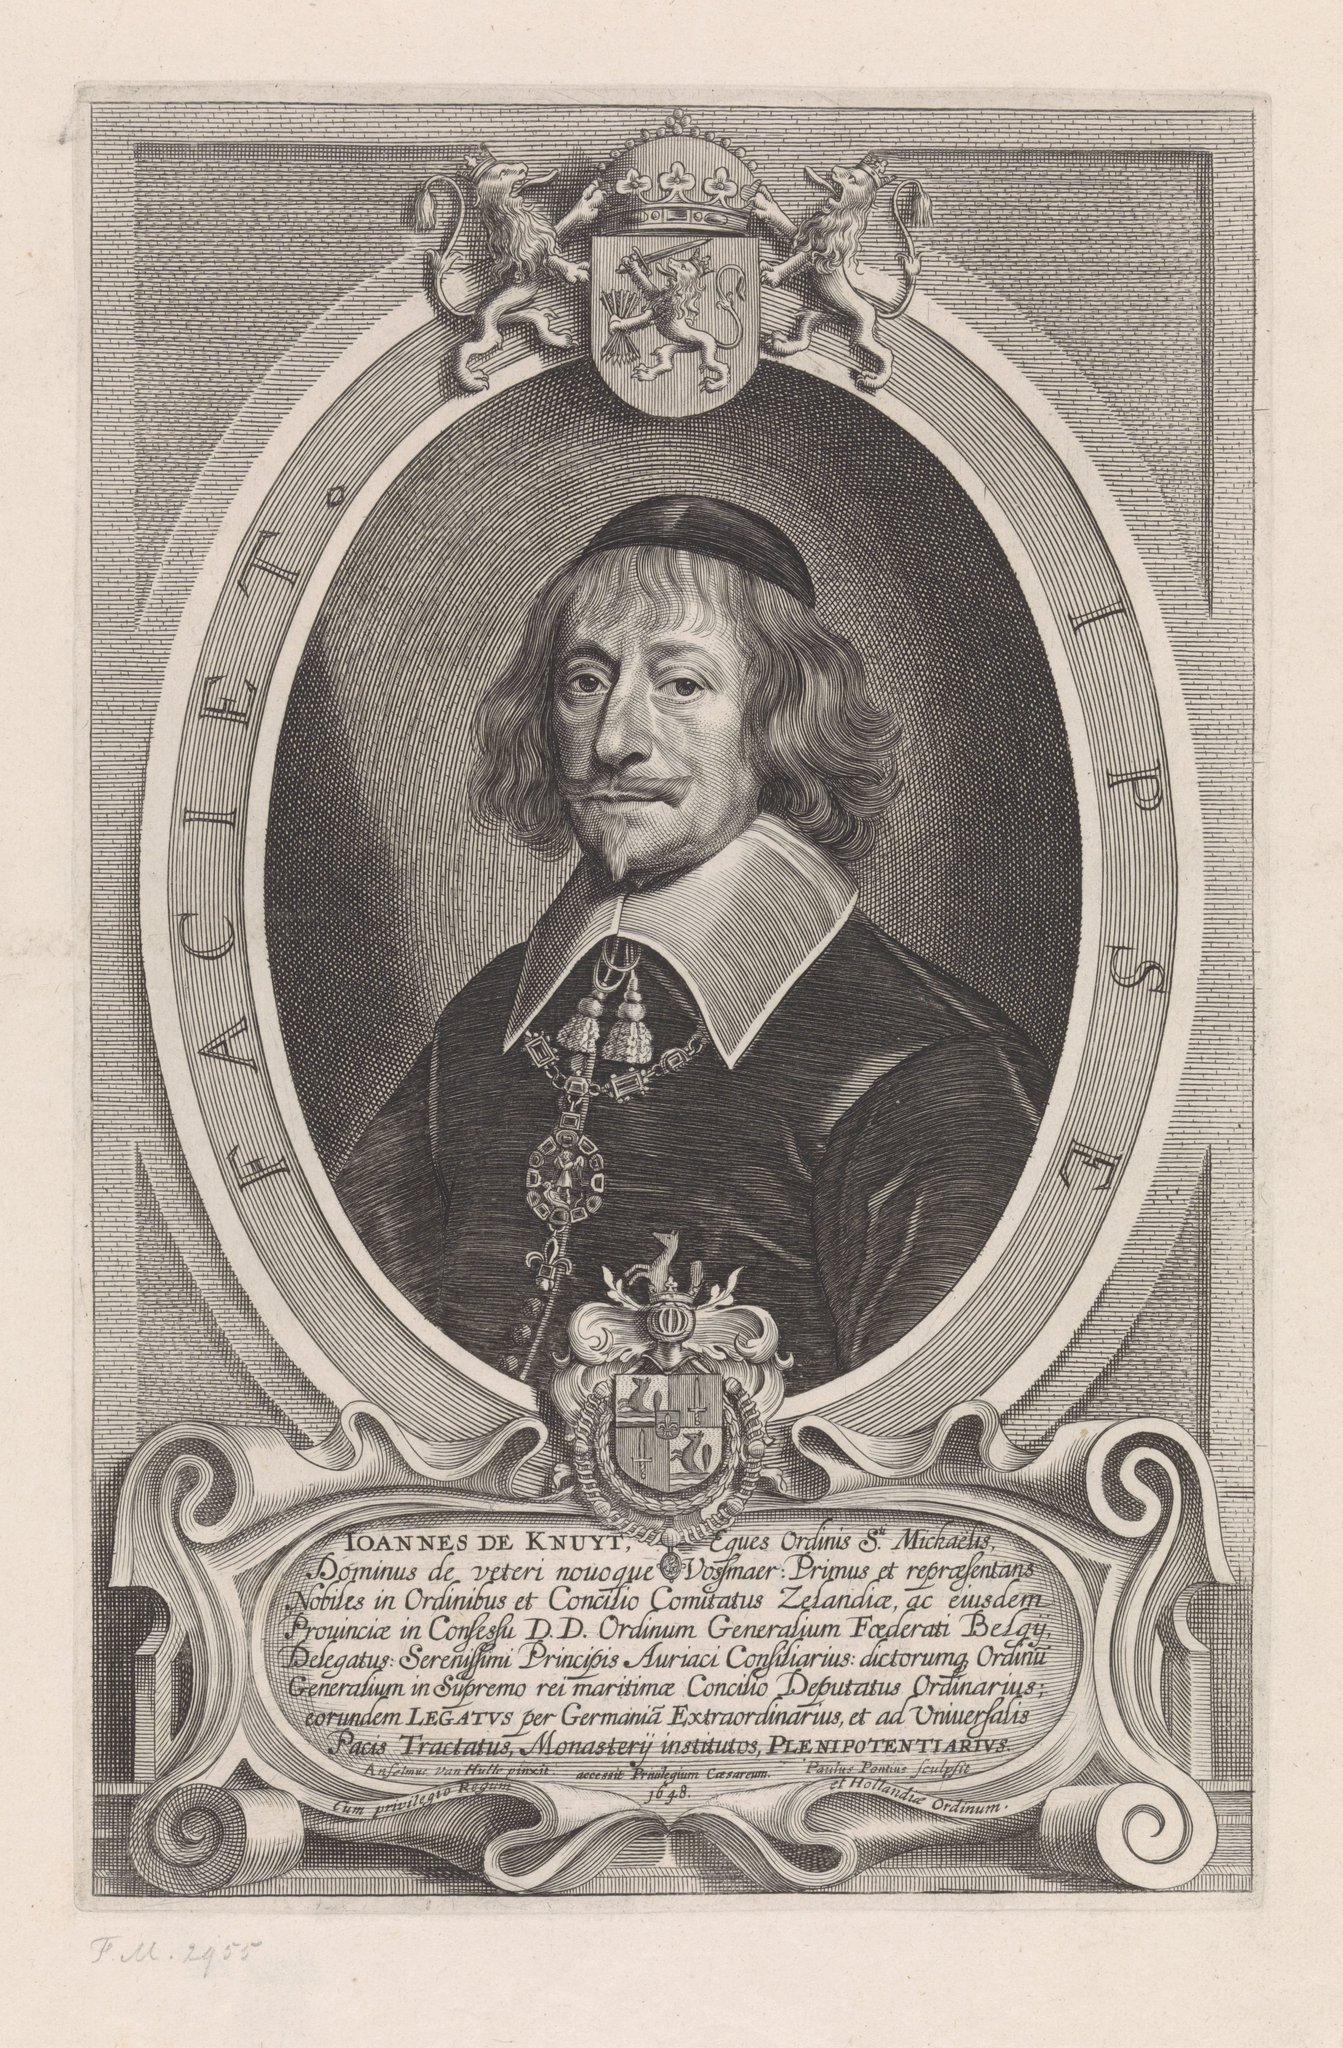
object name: print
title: Portret van Johan de Knuyt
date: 1648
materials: paper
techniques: engraving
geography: antwerp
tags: armorial bearing, heraldry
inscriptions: collector's mark: Lugt 2228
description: Prent ook opgenomen in: Pacificatores orbis christiani, sive Icones principum, ducum et legatorum, qui Monasterii atque Osnabrugæ pacem Europæ reconciliarunt (...). = Pronkbeelden der vorsten, en vredehandelaars. Rotterdam: Pieter van der Slaart, 1697.